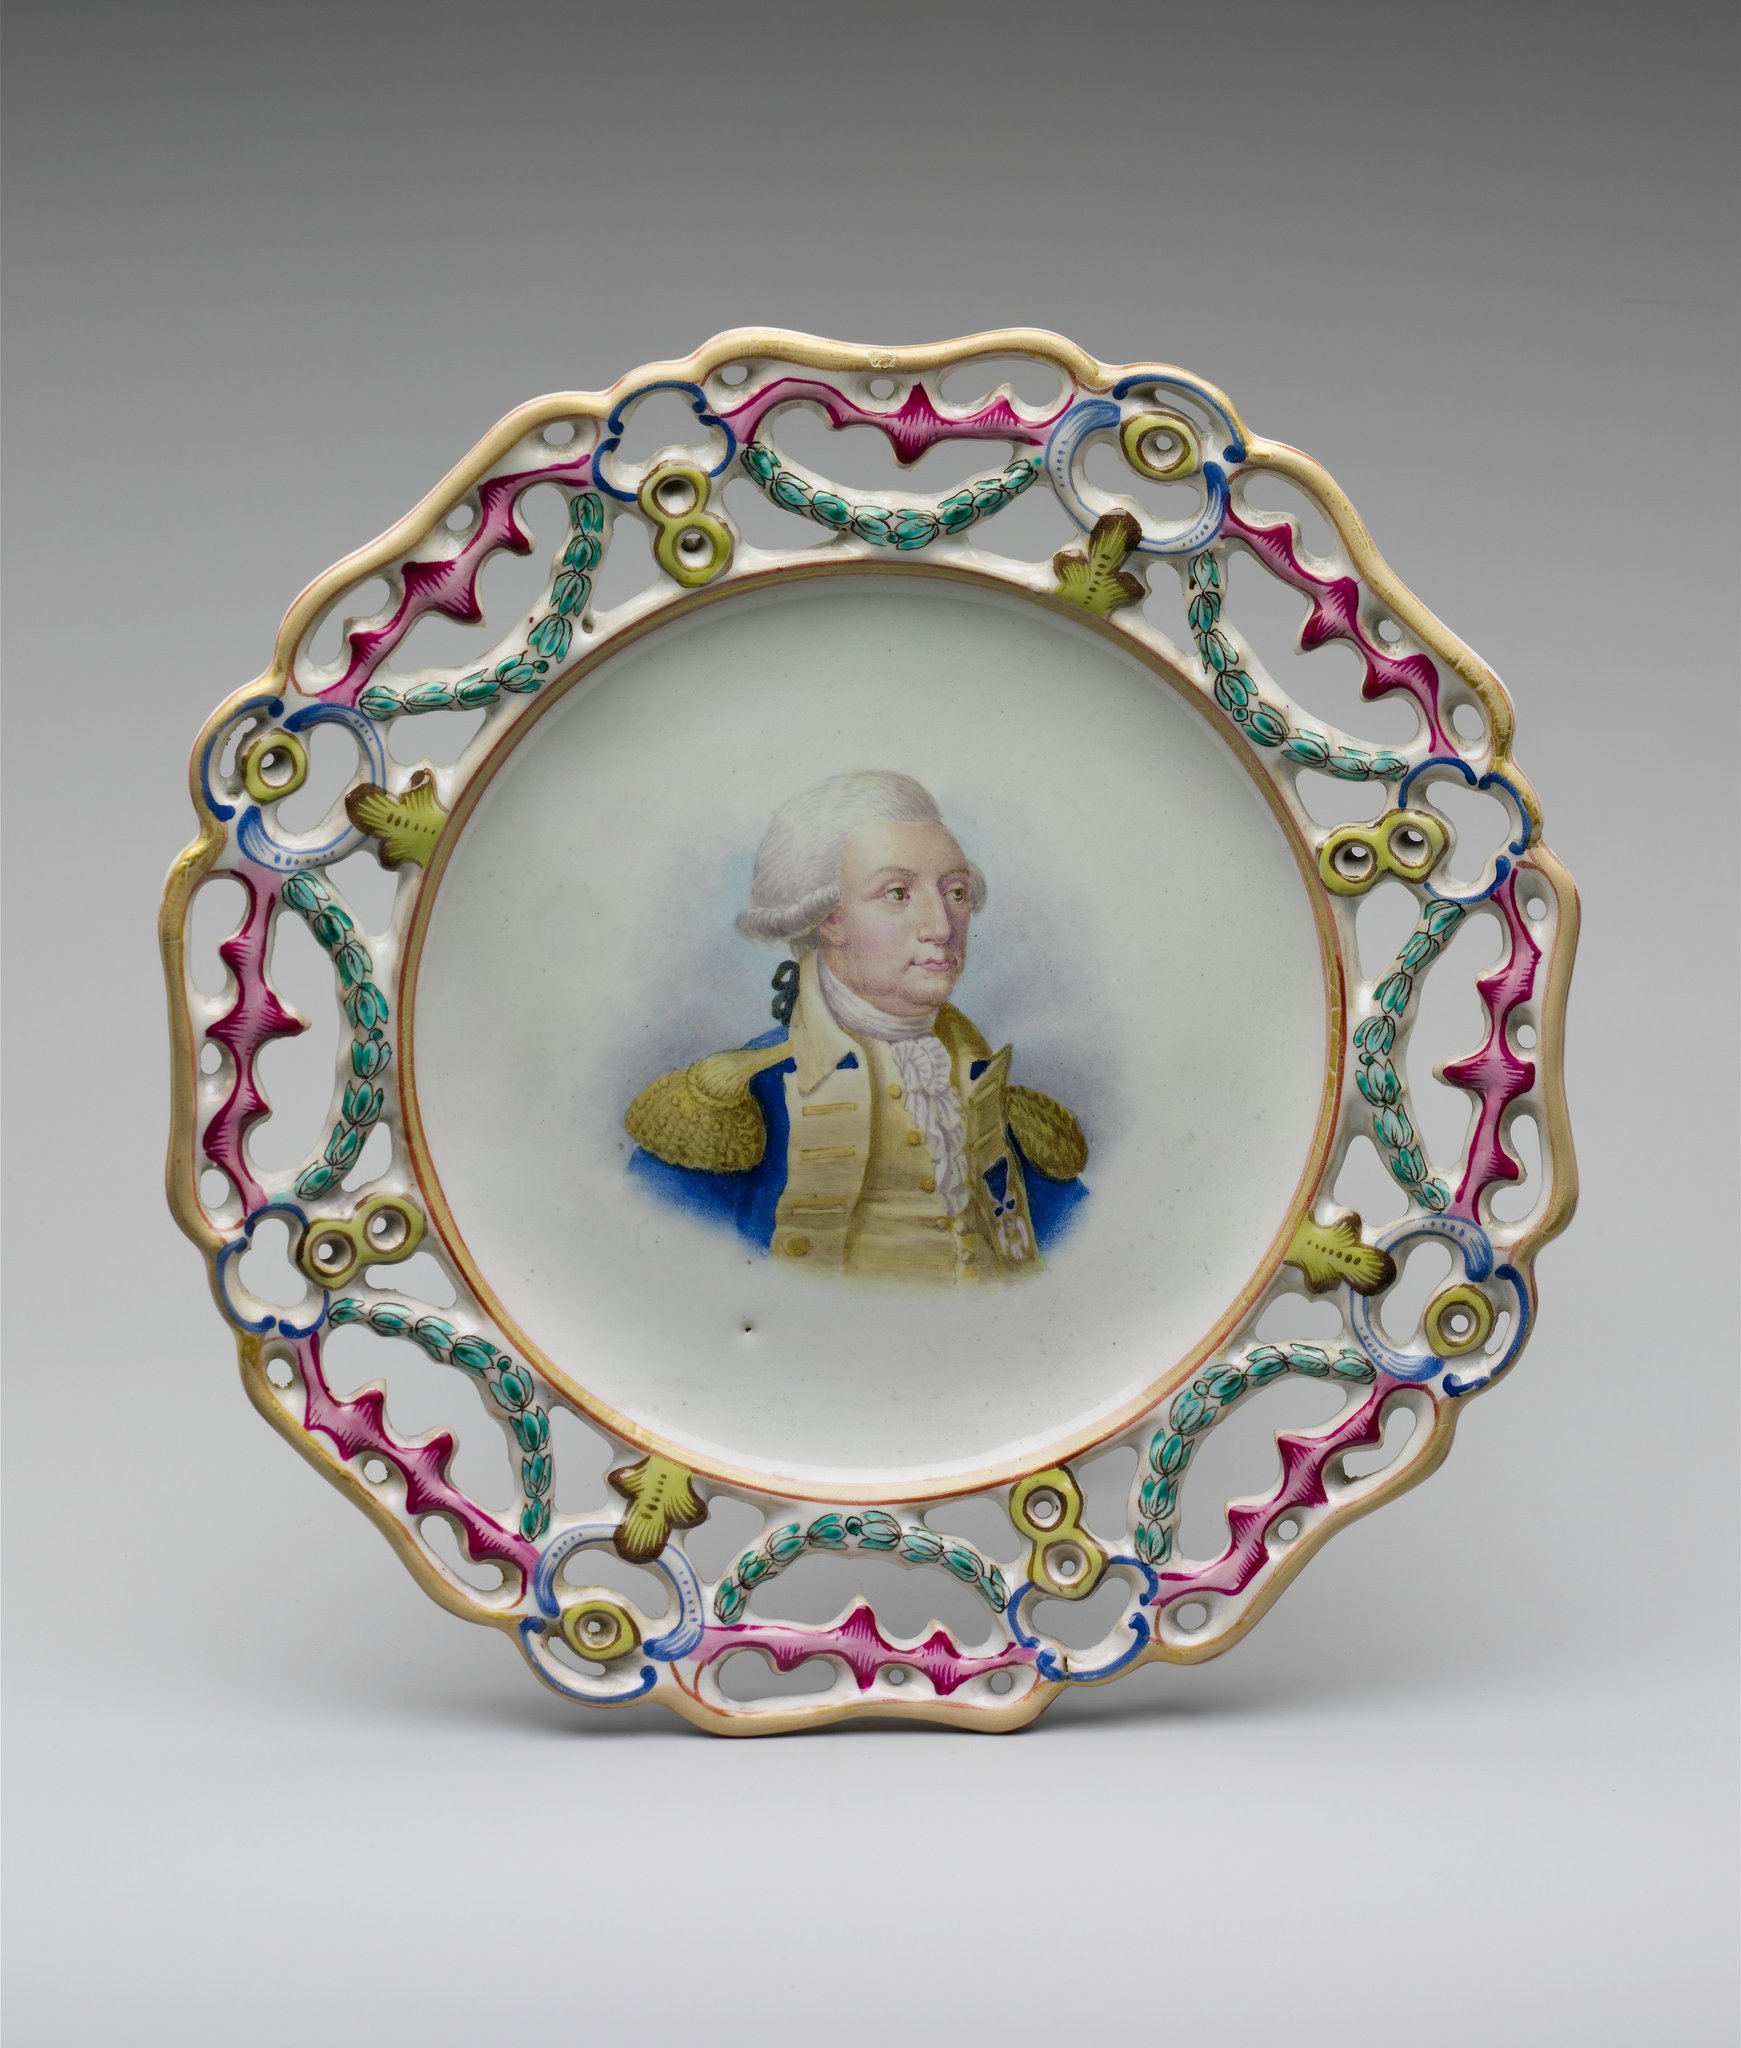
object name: plate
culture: french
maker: pierrette caudelot perrin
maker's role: maker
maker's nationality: french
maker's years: 1740-1793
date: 1770-1800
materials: faience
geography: france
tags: george washington,men,portraits